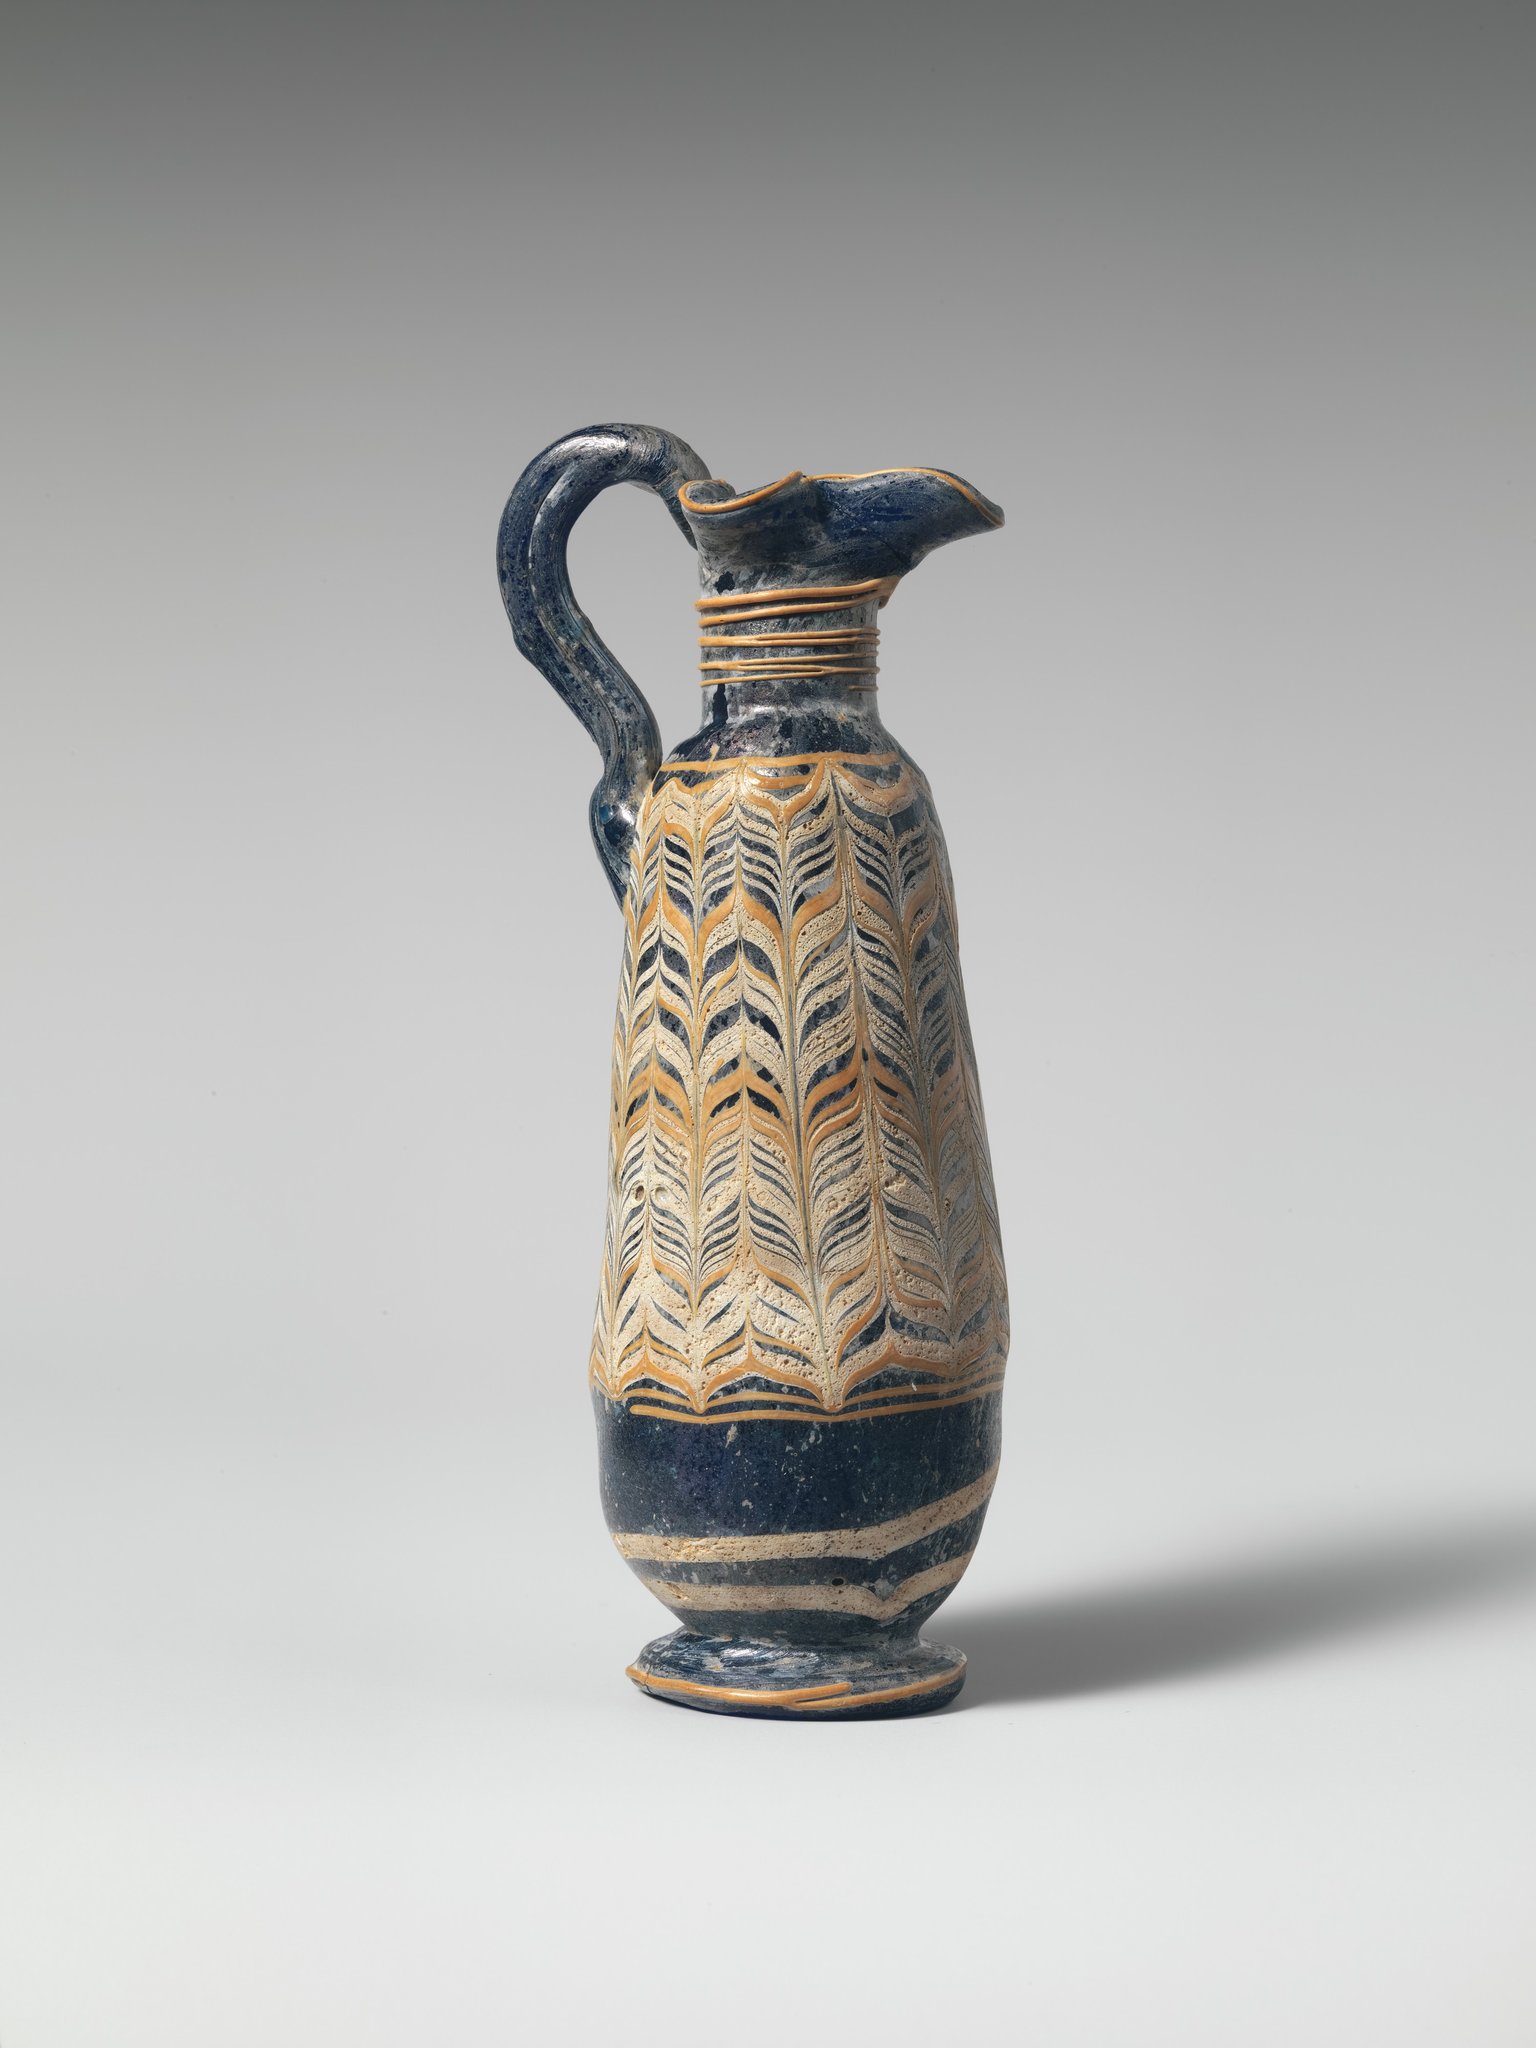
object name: oinochoe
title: Glass oinochoe (perfume jug)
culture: eastern mediterranean or italian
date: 334-268 BCE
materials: glass